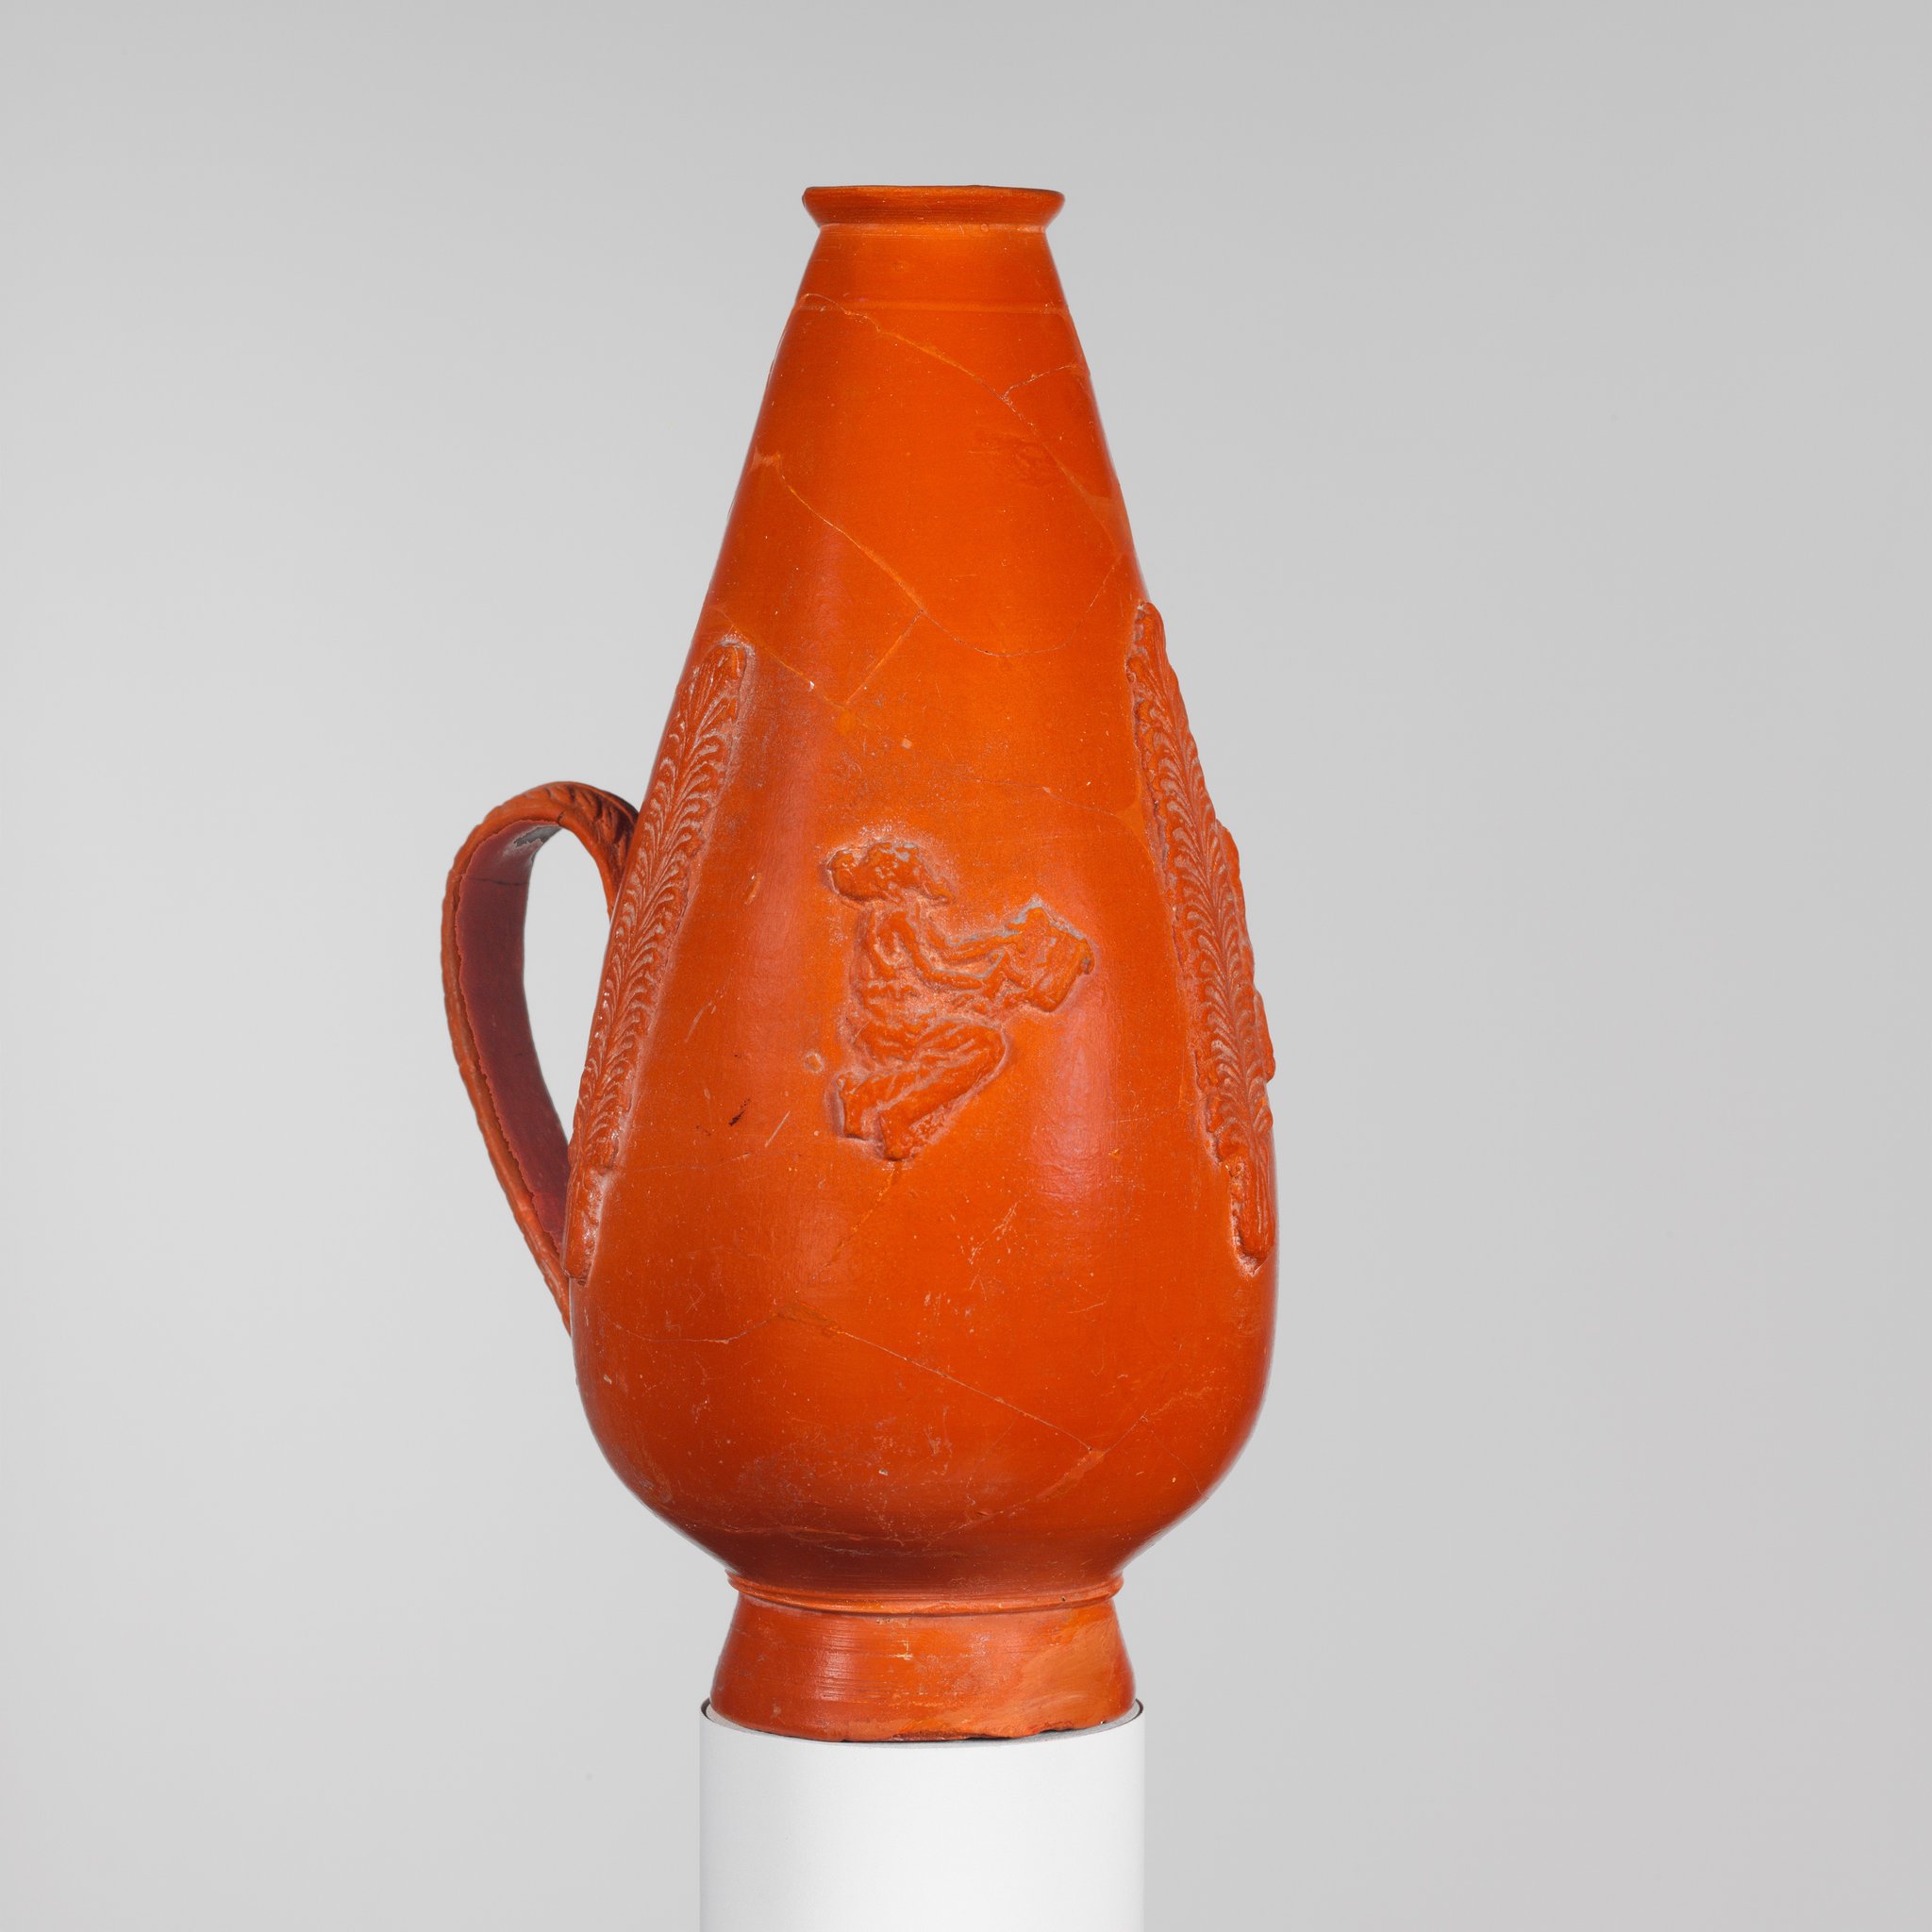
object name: jug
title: Terracotta jug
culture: roman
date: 220-250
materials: terracotta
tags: men